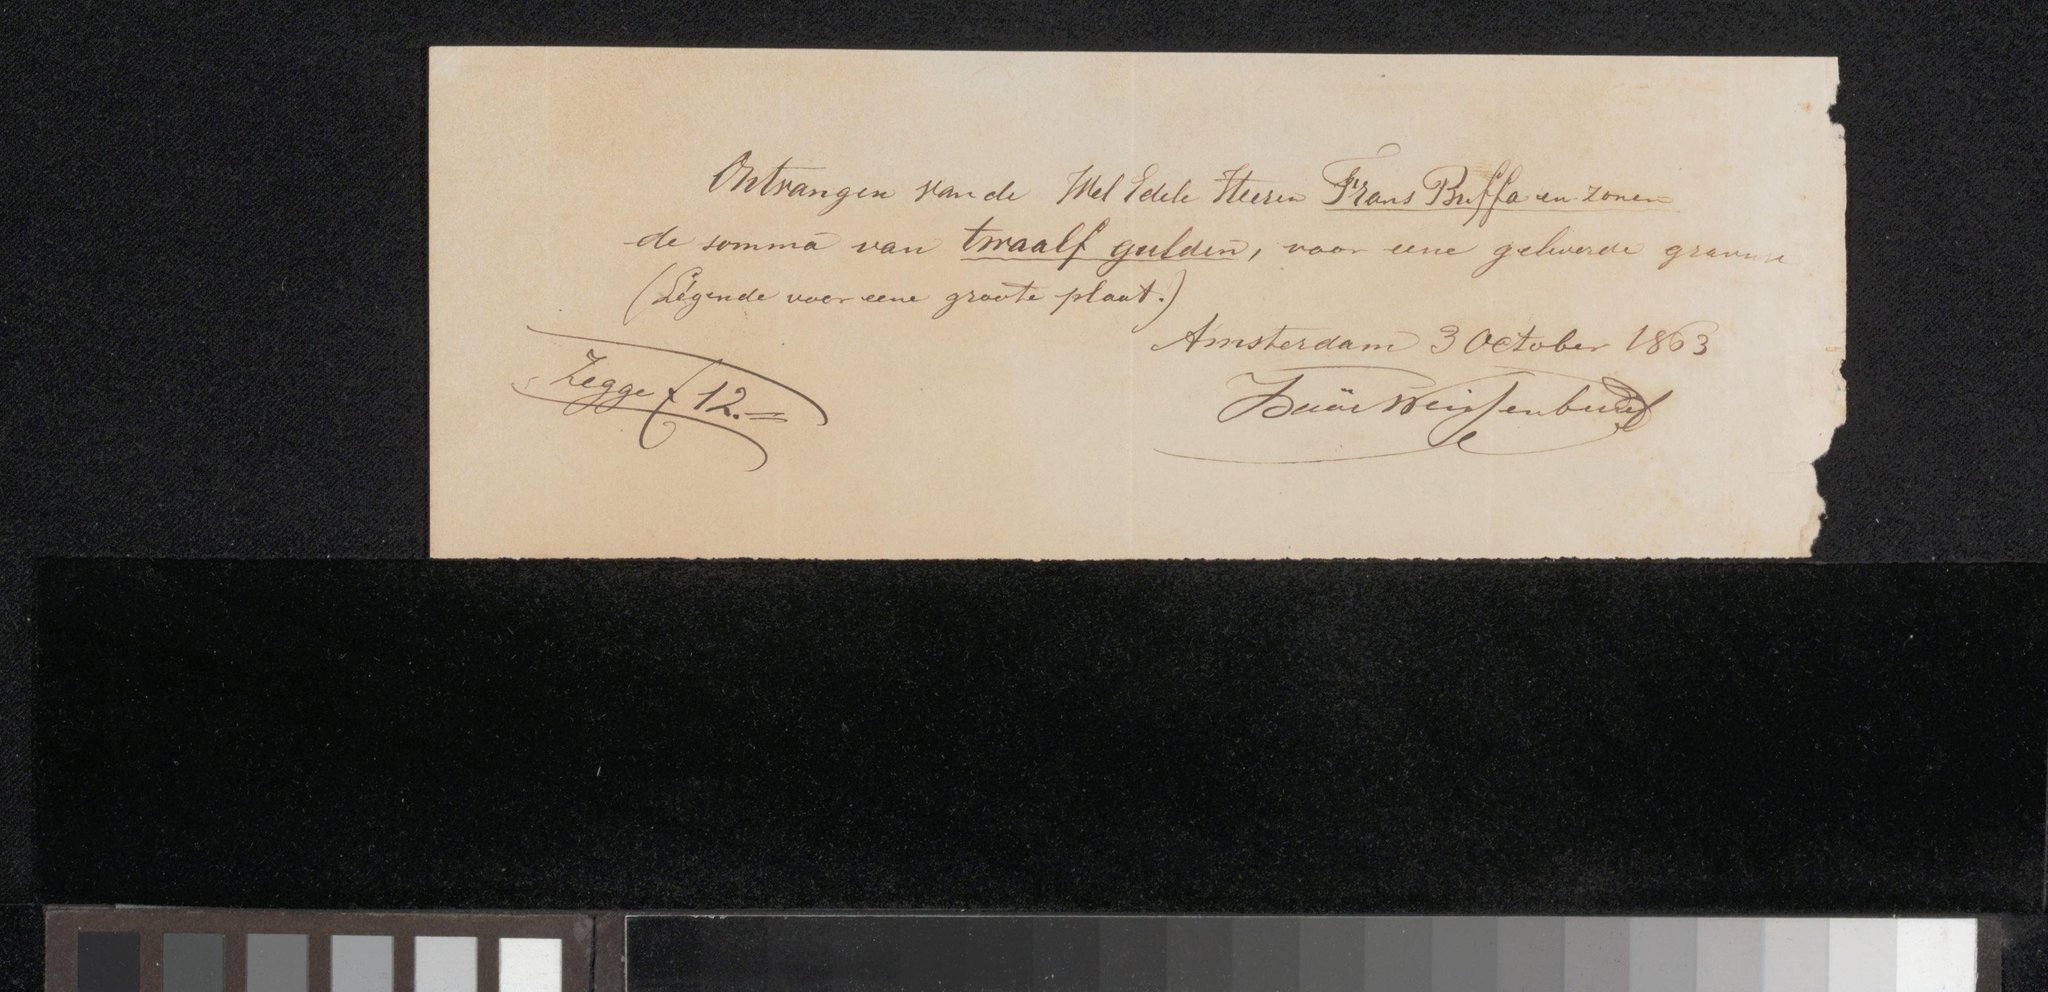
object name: ontvangstbewijs, kwitantie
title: Kwitantie voor Isaac Weissenbruch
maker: isaac weissenbruch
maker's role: print maker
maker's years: 1826-1912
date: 1863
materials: ink, paper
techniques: pen, writing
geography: amsterdam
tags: the graphic arts, money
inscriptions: collector's mark: Lugt 2228, collector's mark: Lugt 2233